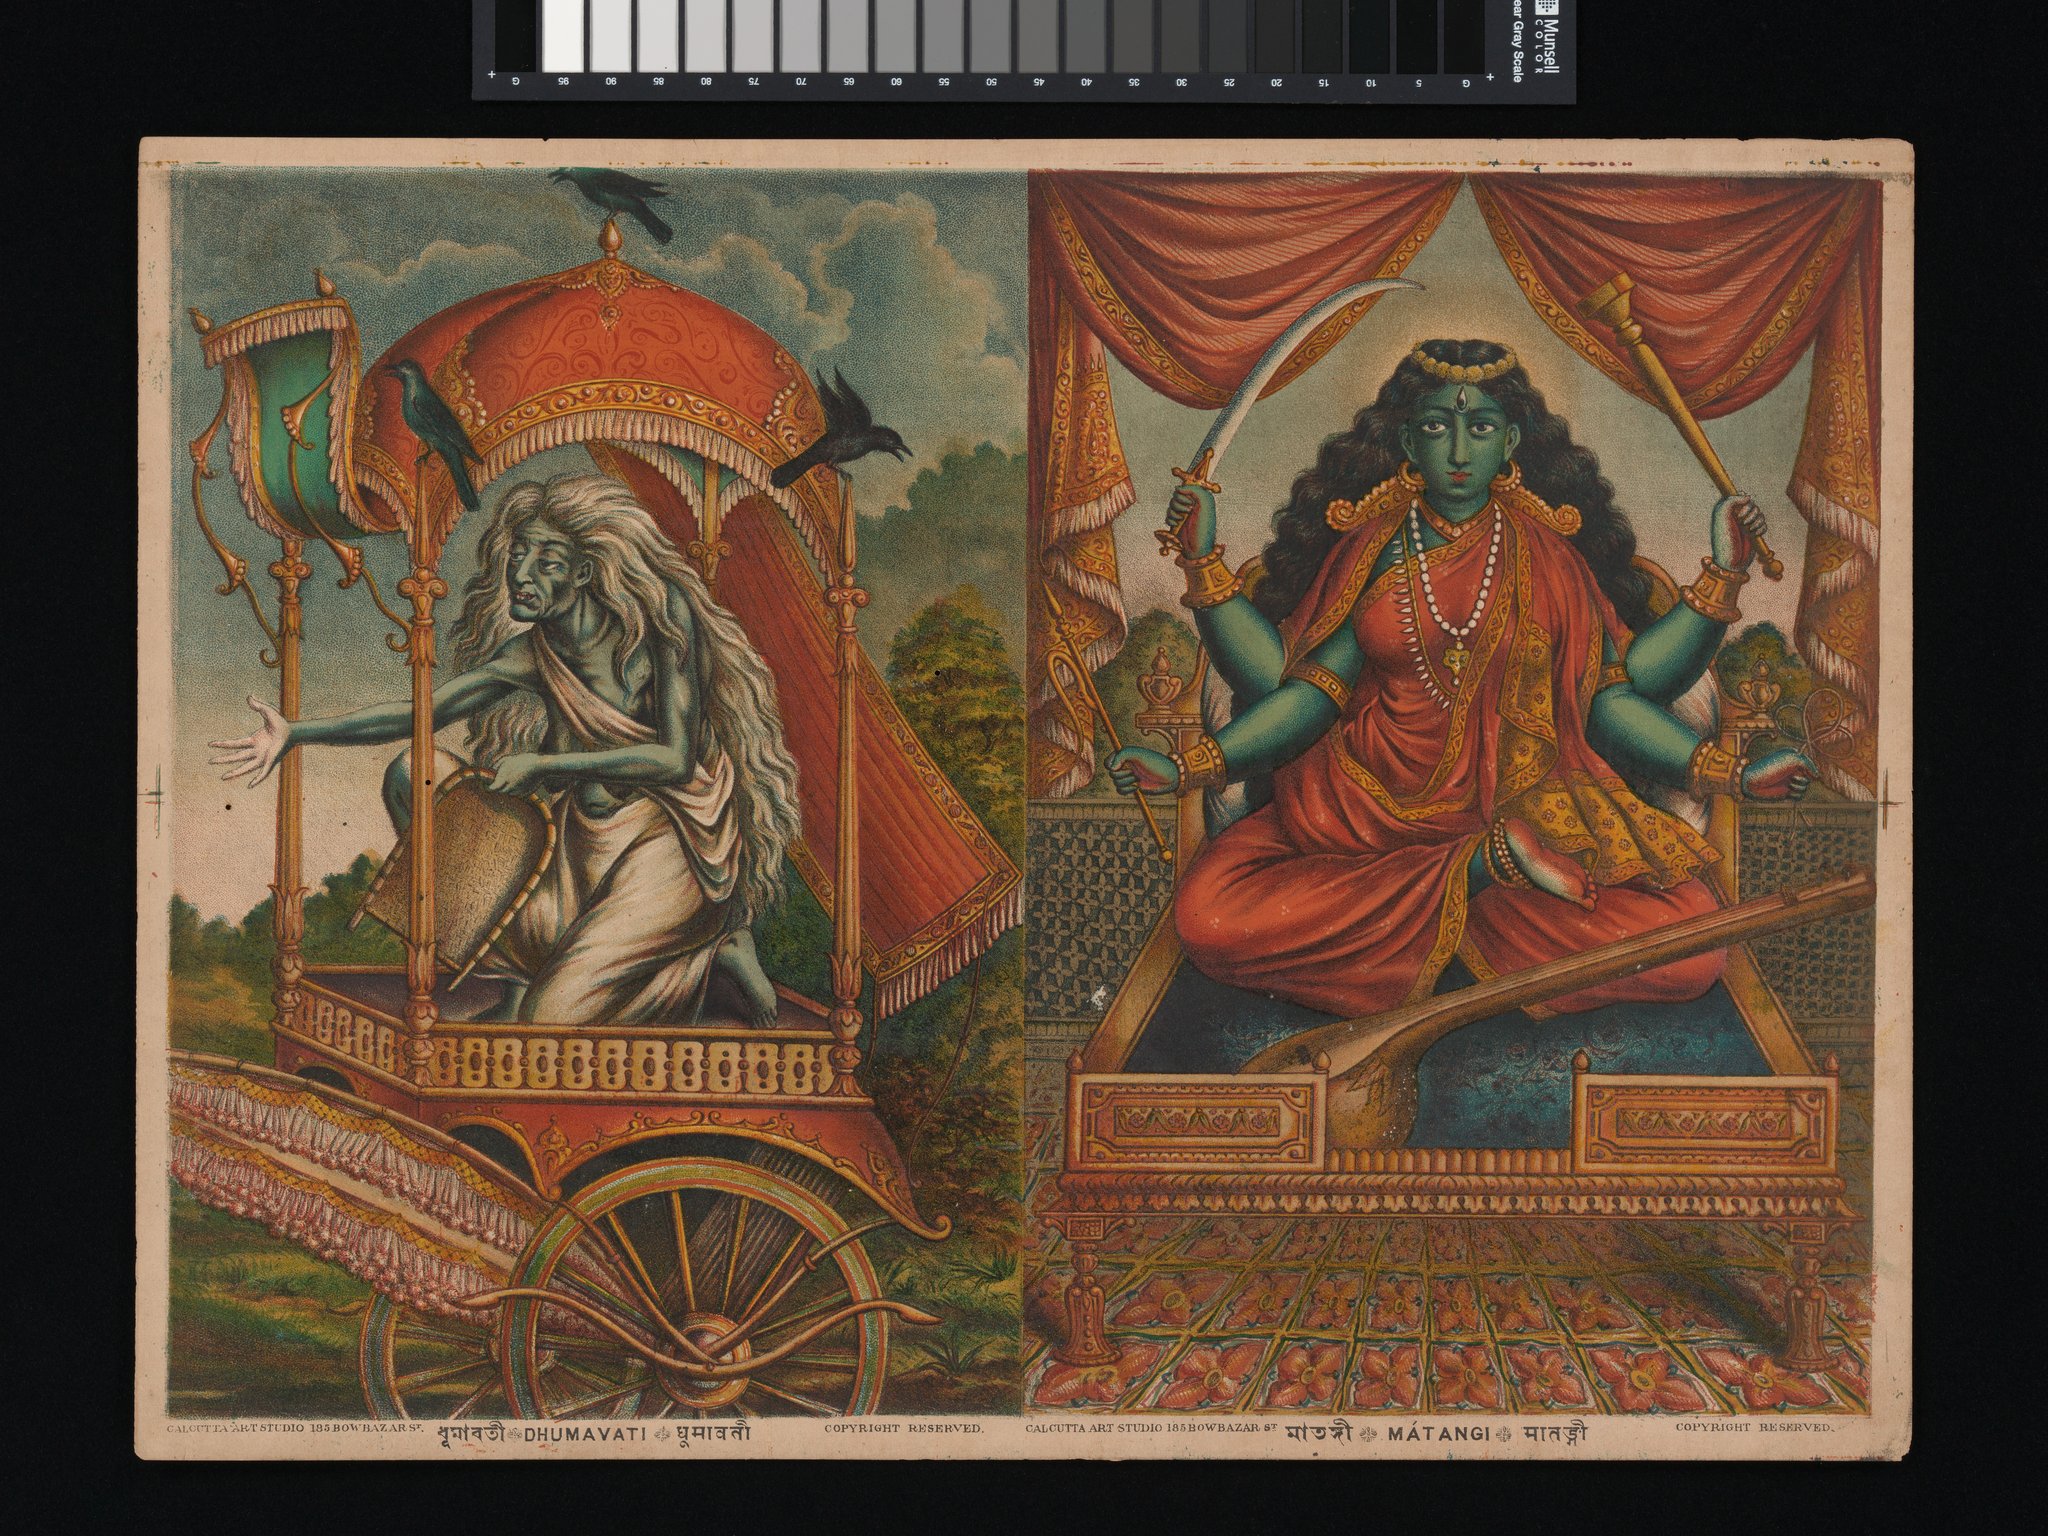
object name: print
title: Dhumavati/ Matangi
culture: indian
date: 1885-1890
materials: chromolithograph, paper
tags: goddess